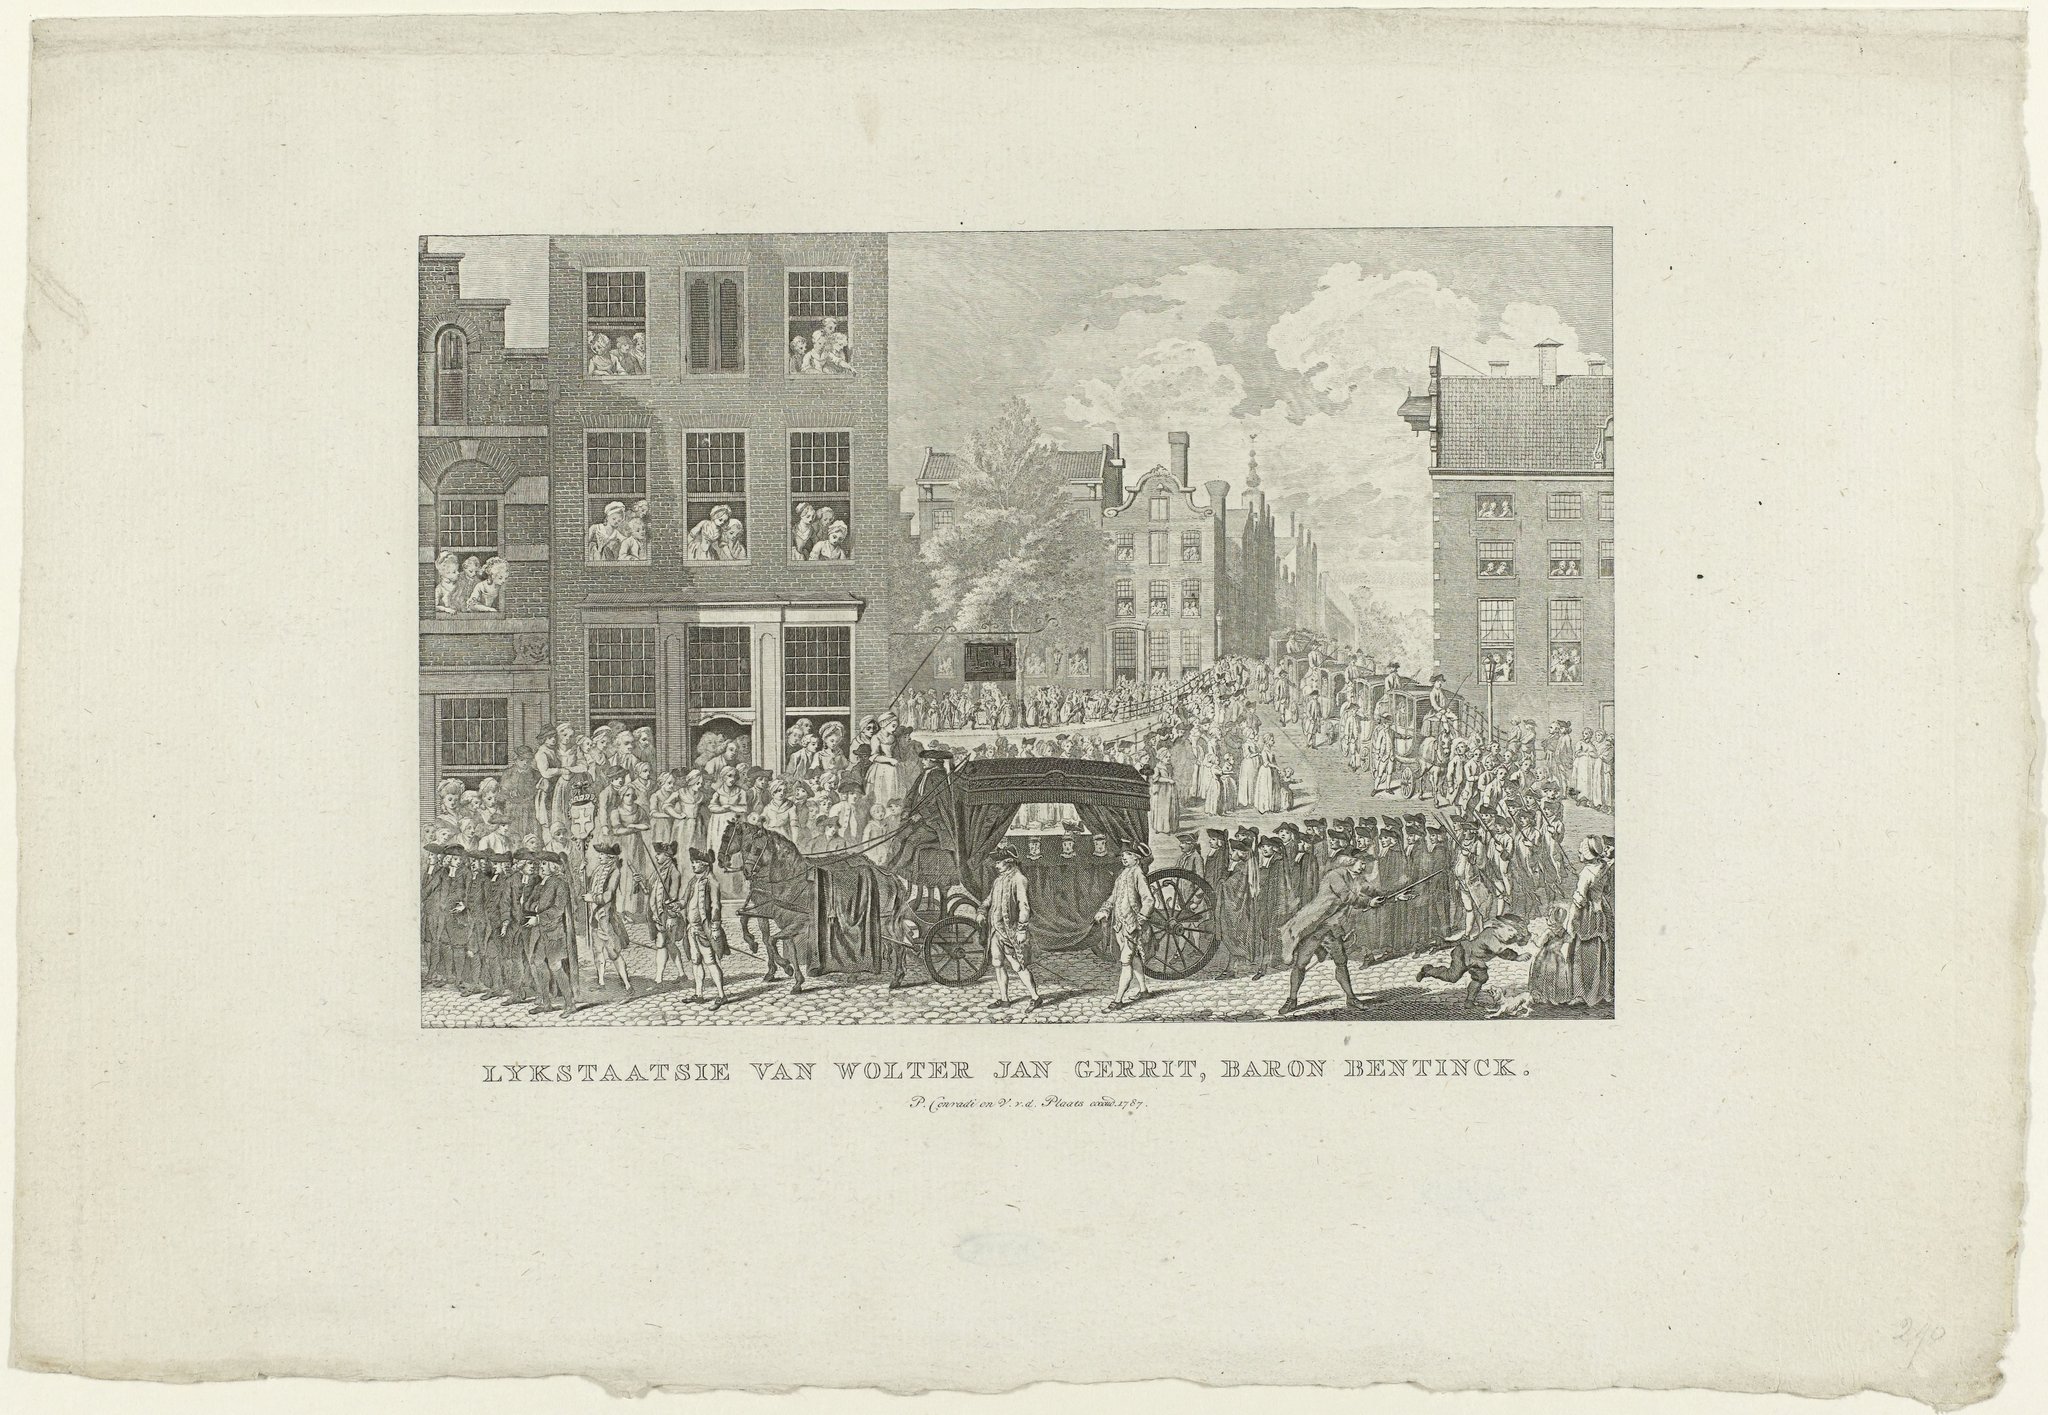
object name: print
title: Lykstaatsie van Wolter Jan Gerrit, Baron Bentinck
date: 1782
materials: paper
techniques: engraving, etching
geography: amsterdam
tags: funeral carriages, cortege, funeral procession, public funeral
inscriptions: collector's mark: Lugt 2228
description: Muller beschrijft onder dit nummer het exemplaar in de collectie Atlas Mr. Simon van Gijn te Dordrecht. Voor eerste bekende staat zie RP-P-OB-85.212. Voor tweede bekende staat zie RP-P-OB-66.099 en RP-P-1878-A-1766. Voor derde bekende staat zie RP-P-AO-28-110. Eerdere staat van deze prent was bestemd voor gebruik als illustratie in: Francq van Berkhey, Johannes le. De zeetriumph der Bataafsche vryheid, op Doggersbank. Bevochten den 5den van Oogstmaand 1781. 2 delen. Amsterdam: Johannes Allart, 1782. De prent was echter niet op tijd klaar om in het boek opgenomen te worden, maar werd alsnog later door de uitgever aan de intekenaren geleverd.